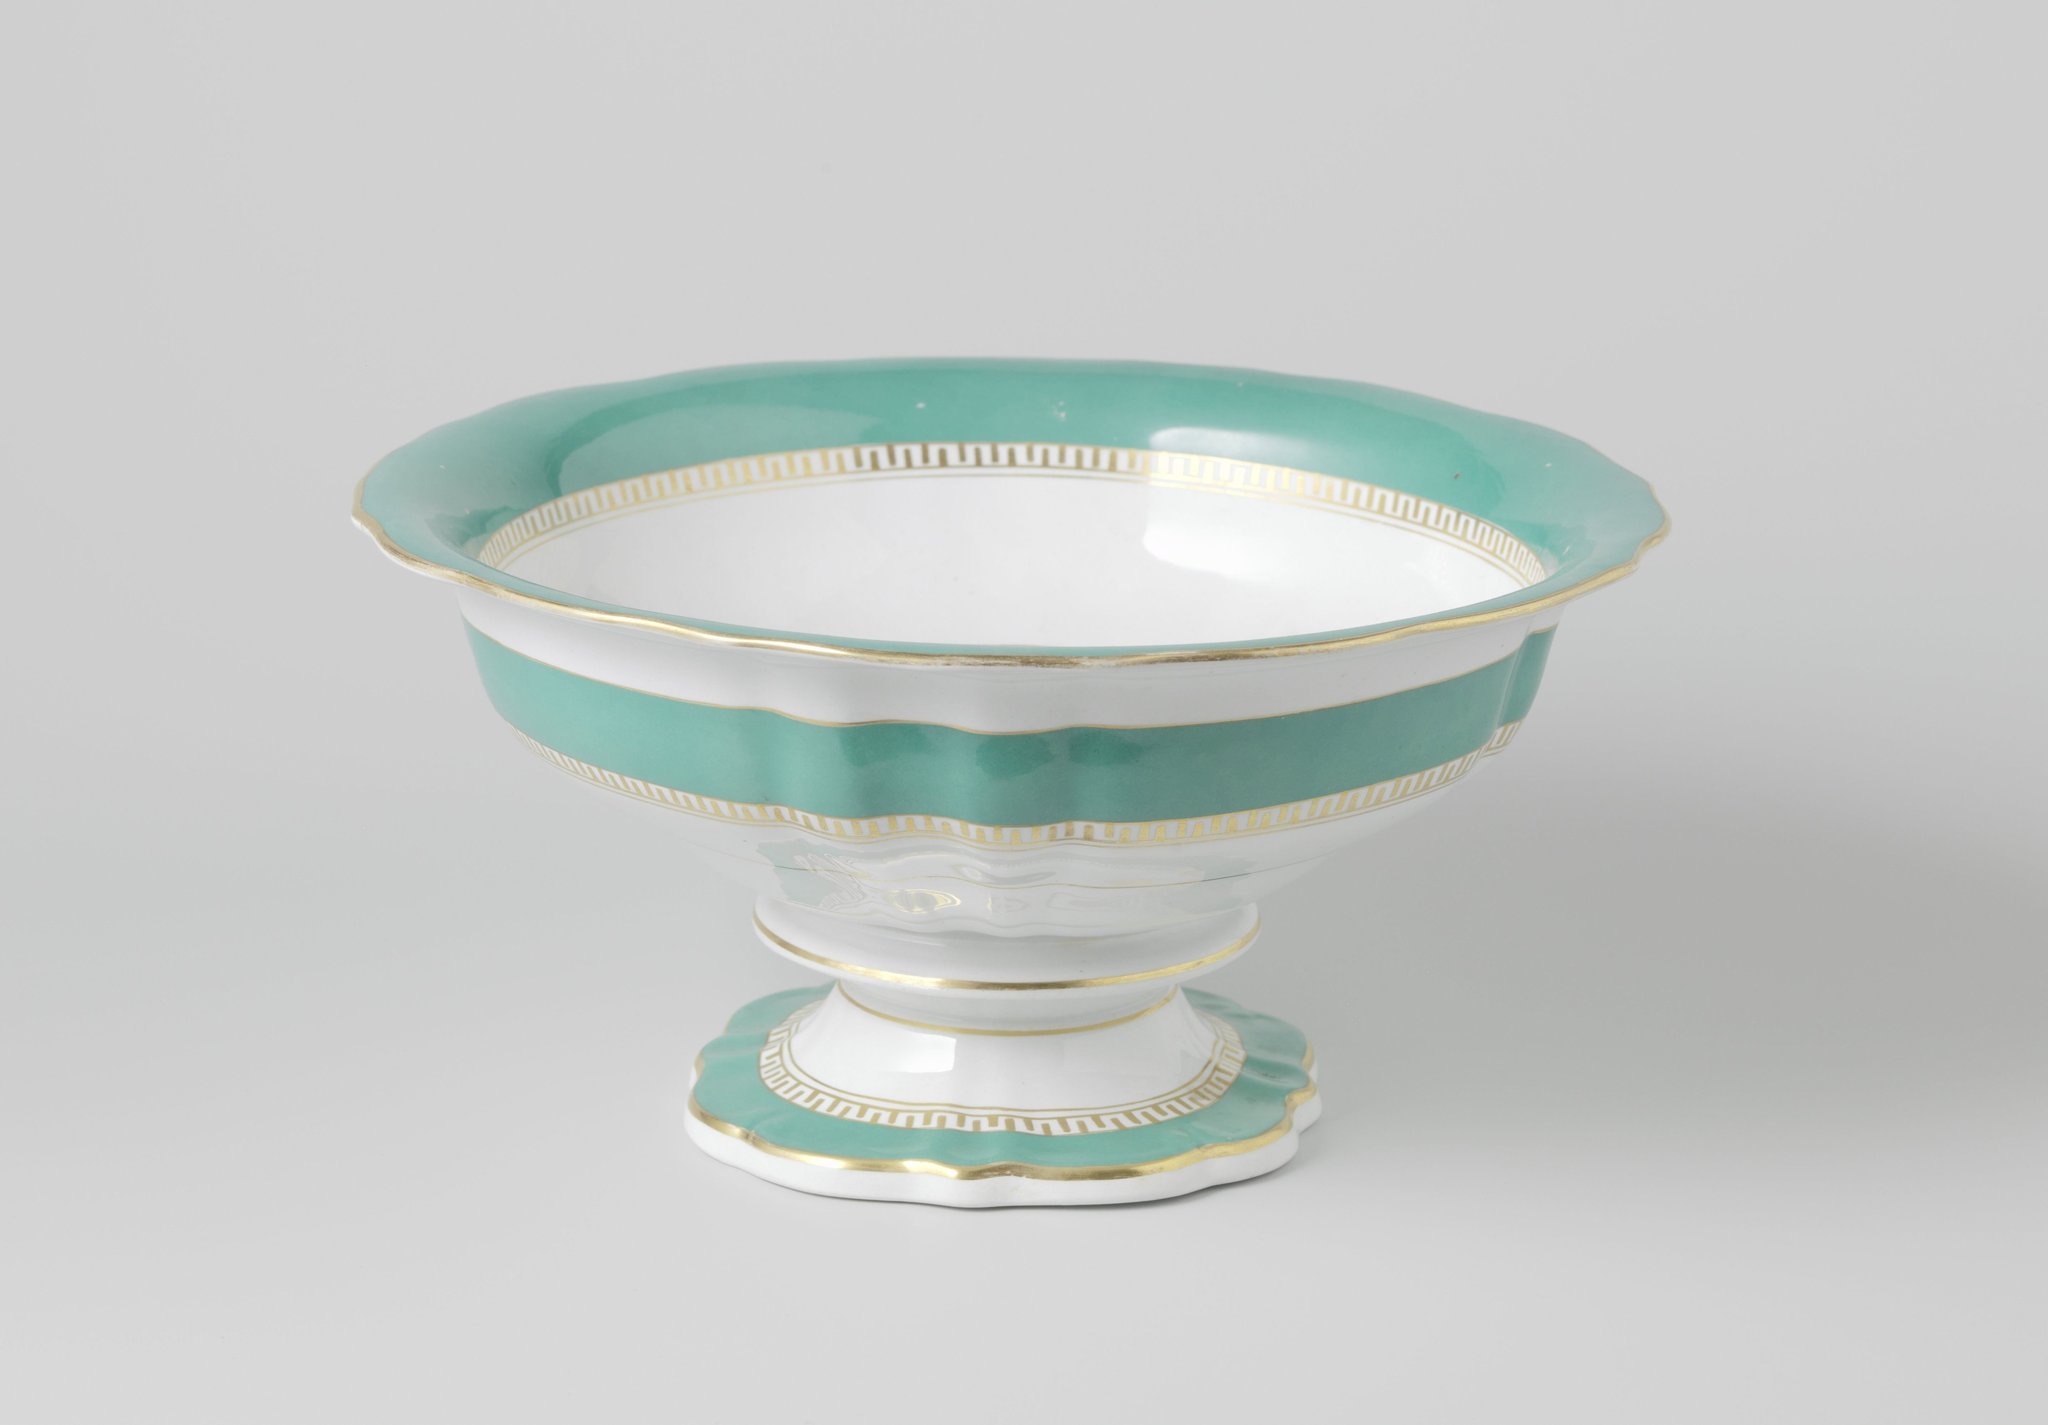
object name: dish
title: Schaal op voet met groene rand en gouden Griekse band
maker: petrus regout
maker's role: plateelbakker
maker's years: 1801-1879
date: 1865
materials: earthenware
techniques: transfer decoration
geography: maastricht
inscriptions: check stamp: ‘P. REGOUT // MAASTRICHT // 2X 10’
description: Schaal op voet van aardewerk, geschulpt, met groene rand en gouden Griekse band.